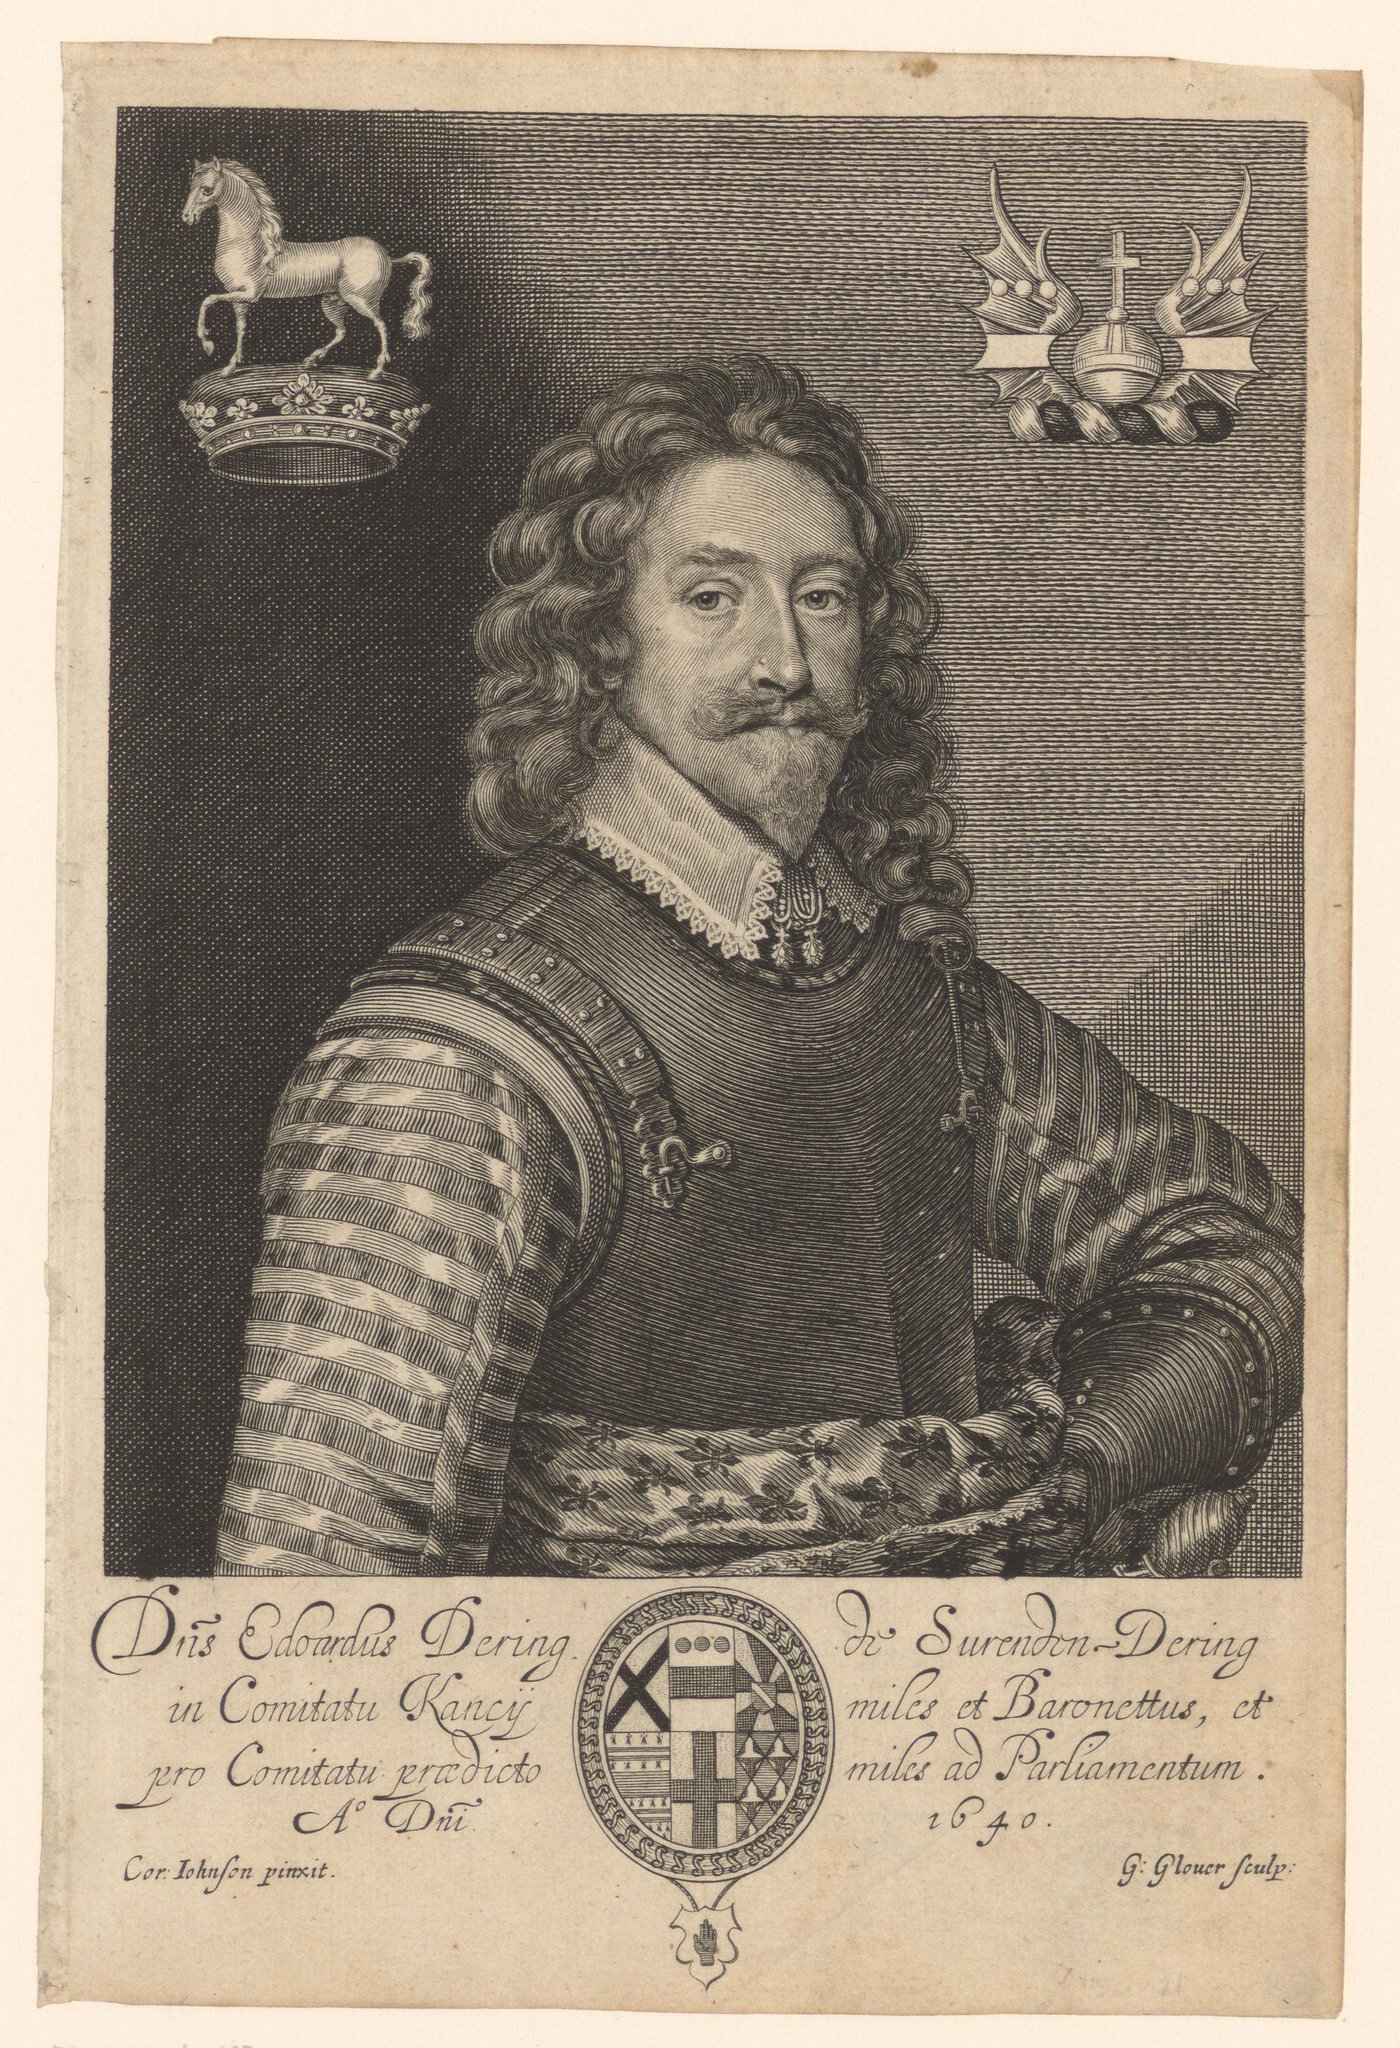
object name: print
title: Portret van Edward Dering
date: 1640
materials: paper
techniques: engraving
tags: politician, historical persons, politician, e.g. party leader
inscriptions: collector's mark: Lugt 2228